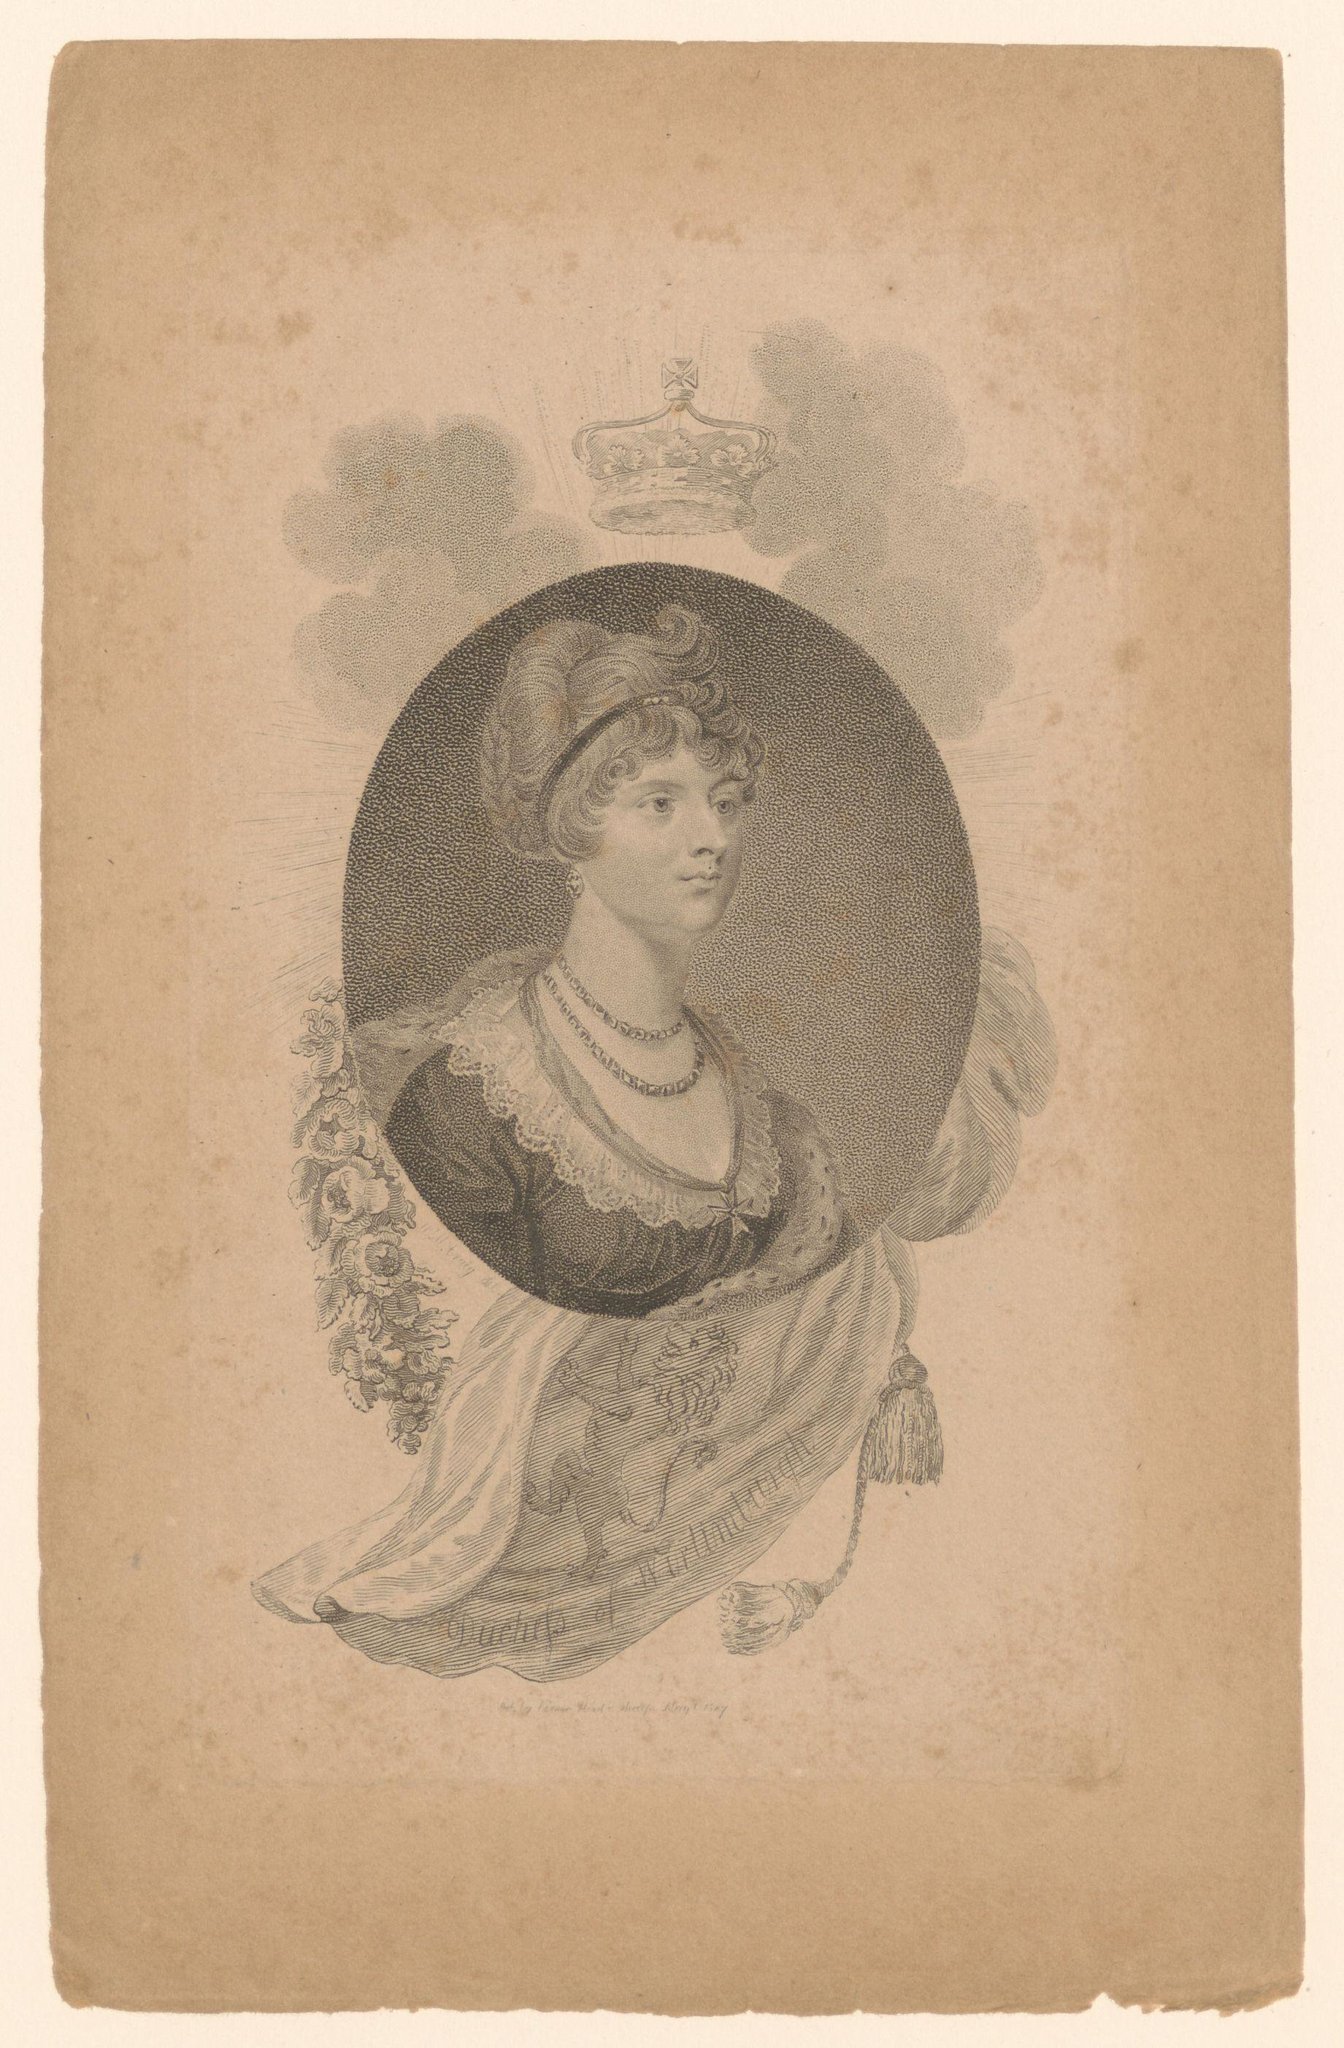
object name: print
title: Portret van Charlotte van Hannover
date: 1807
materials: paper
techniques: etching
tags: london, politician, historical persons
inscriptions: collector's mark: Lugt 2228